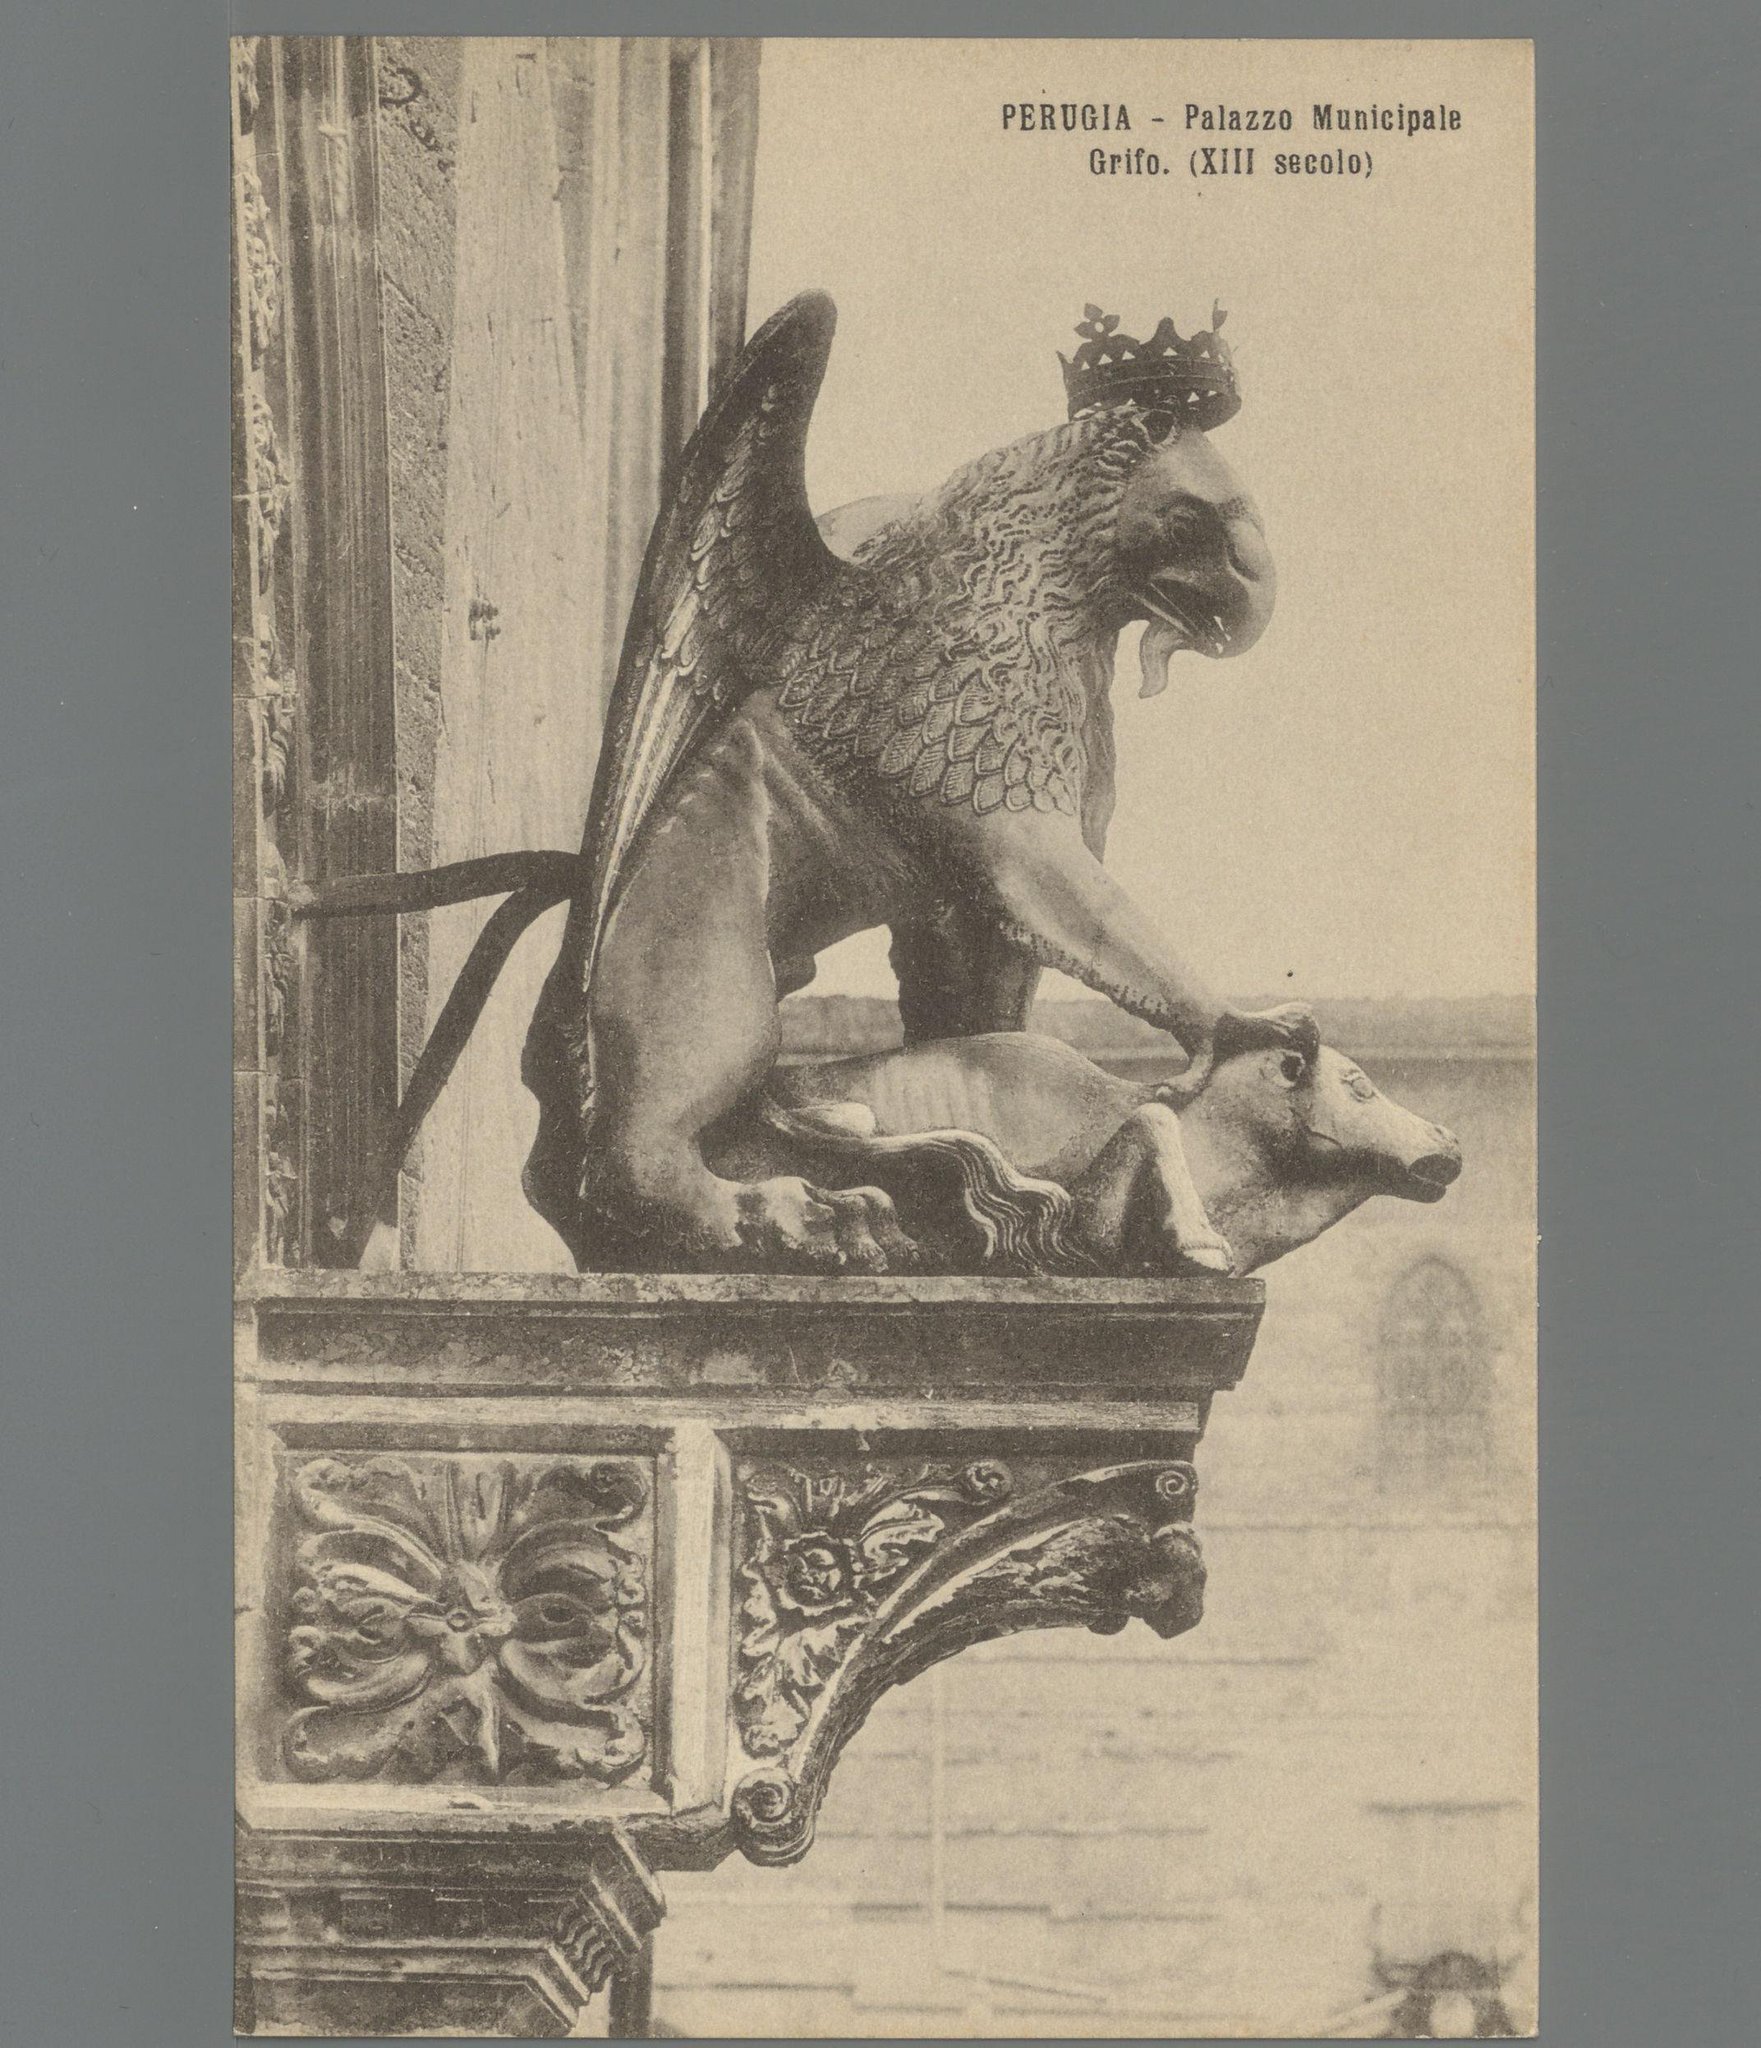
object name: ansichtkaart, prentbriefkaart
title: Perugia. Palazzo Municipale. Grifo (XIII secolo)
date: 1906-1920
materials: cardboard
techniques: photograph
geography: perugia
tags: griffin (lion/eagle); 'griffo' (ripa), palace, sculpture